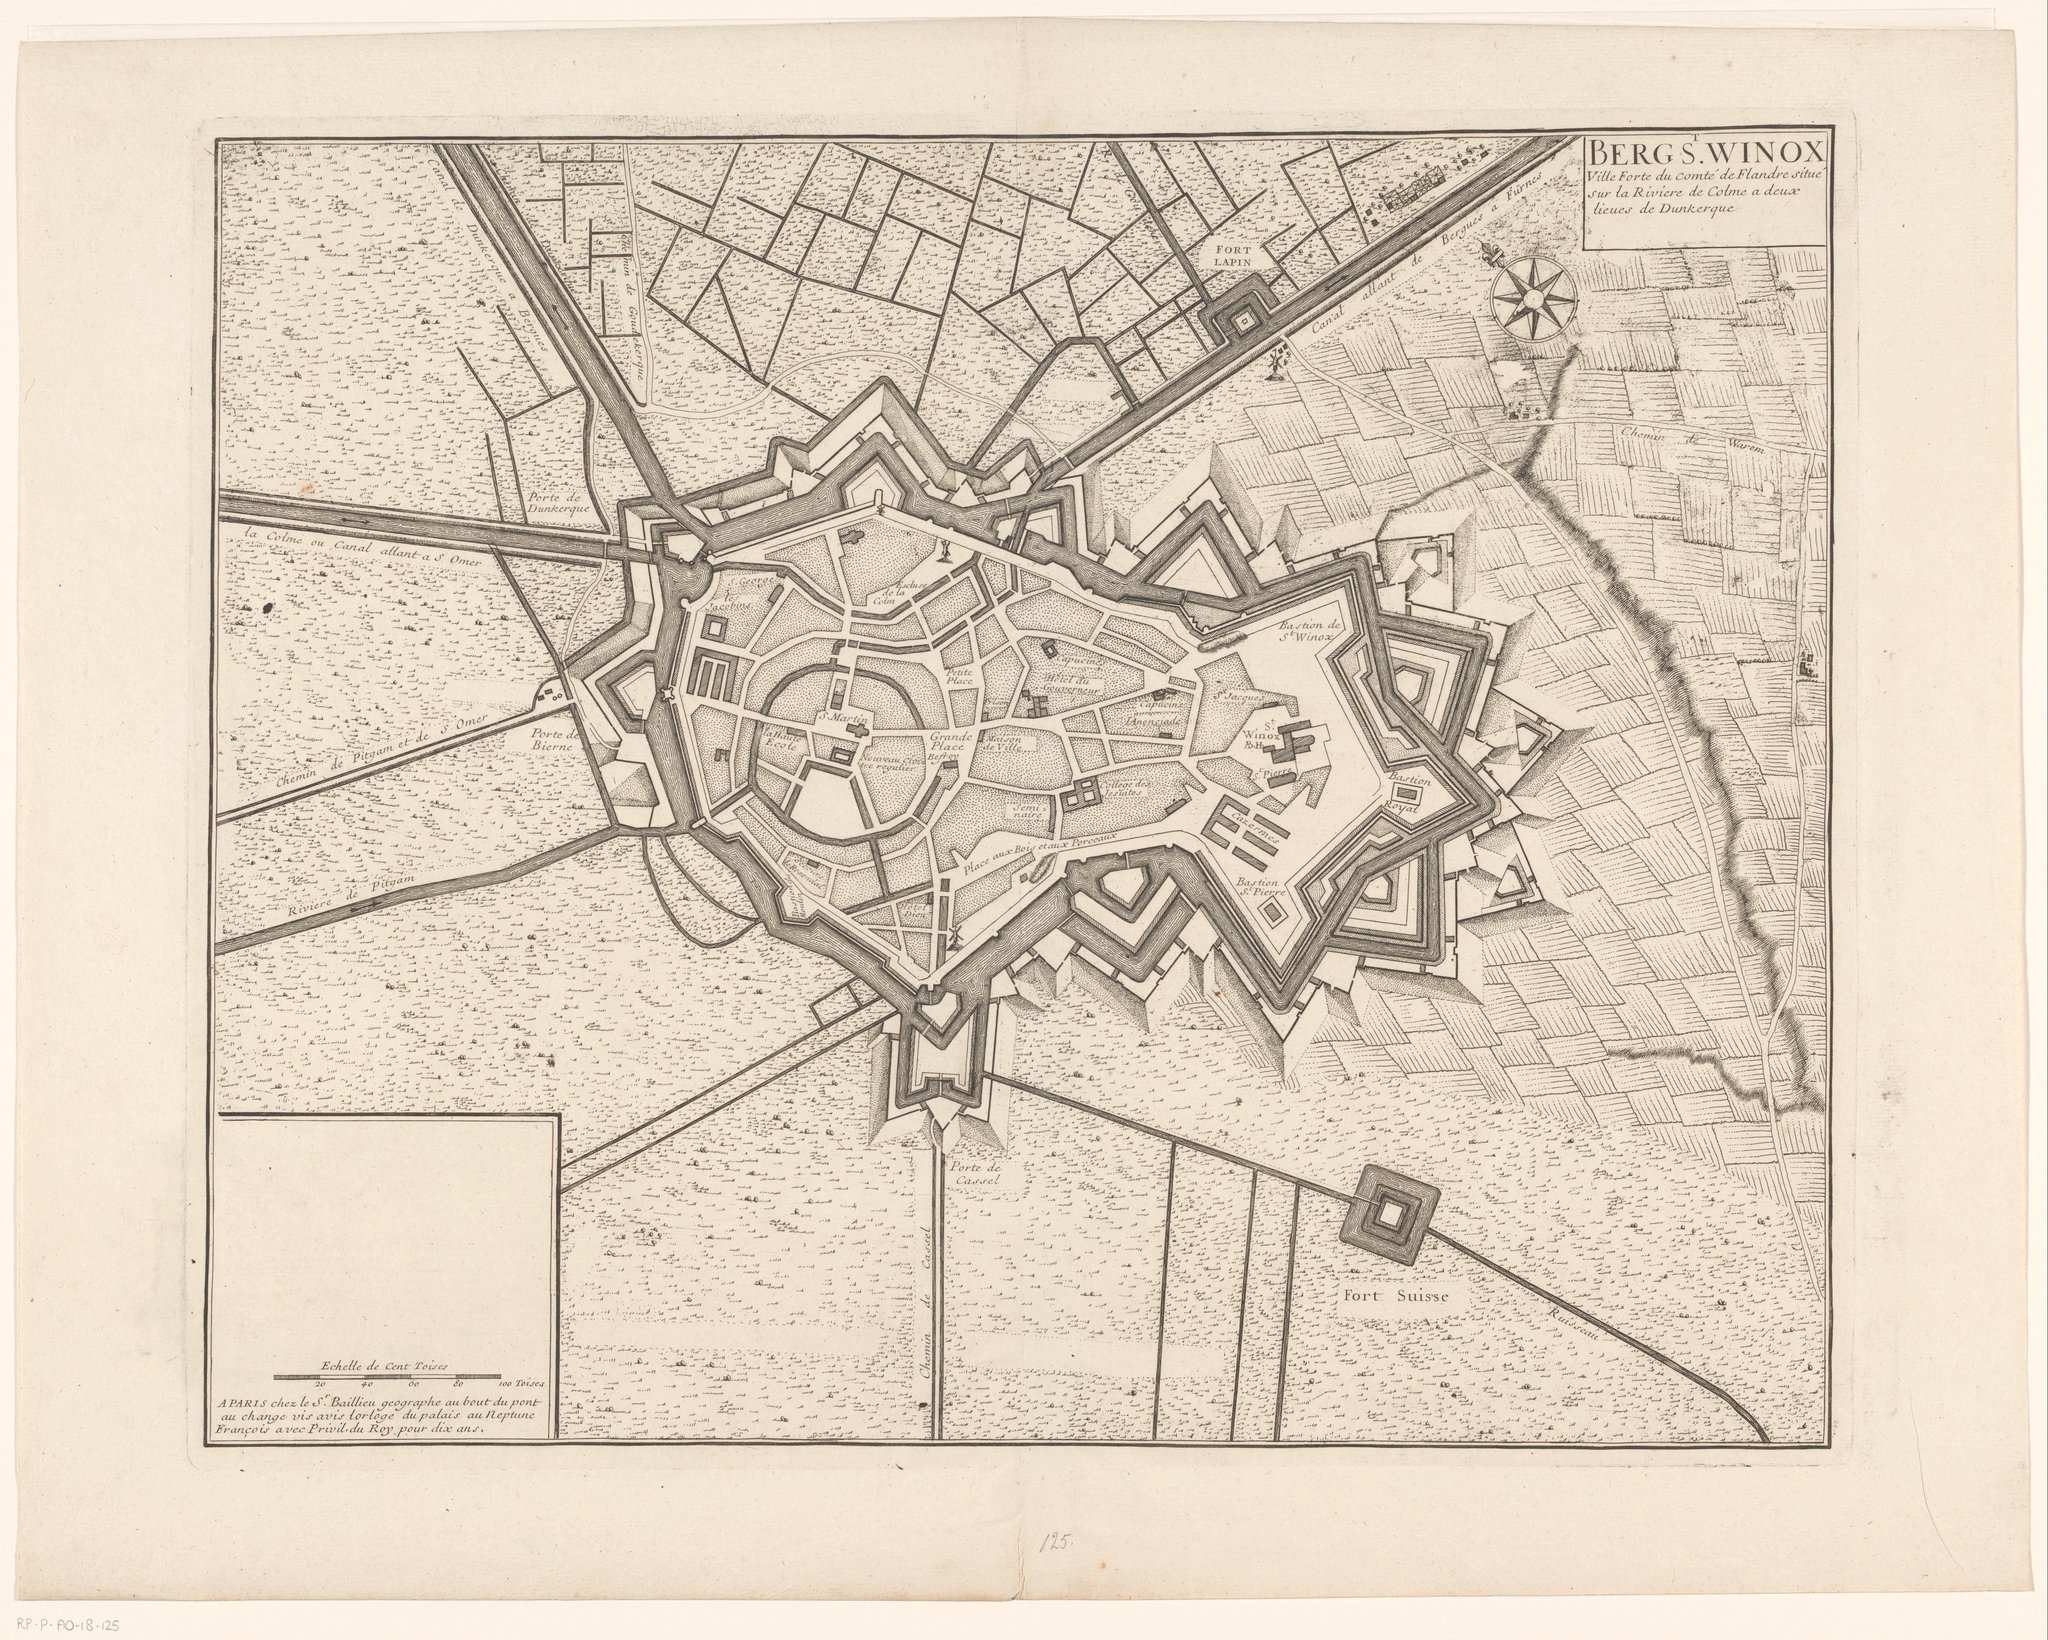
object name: print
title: Berg St. Winox. Ville forte du comté de Flandre situé sur (...)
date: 1690-1744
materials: paper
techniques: etching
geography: paris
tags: fortified city, maps of cities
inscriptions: collector's mark: Lugt 2228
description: Vestingplattegrond van Sint-Winoksbergen. Rechtsboven een kader met de titel. Linksonder een kader met schaalstok: Echelle de cent Toises.